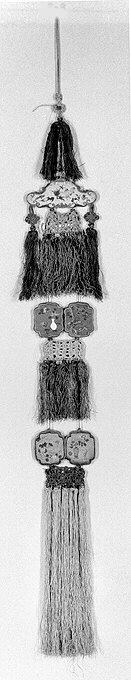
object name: hanging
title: Small Hanging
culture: chinese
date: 1801-1900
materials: gold, mother of pearl, silk, silver, thread